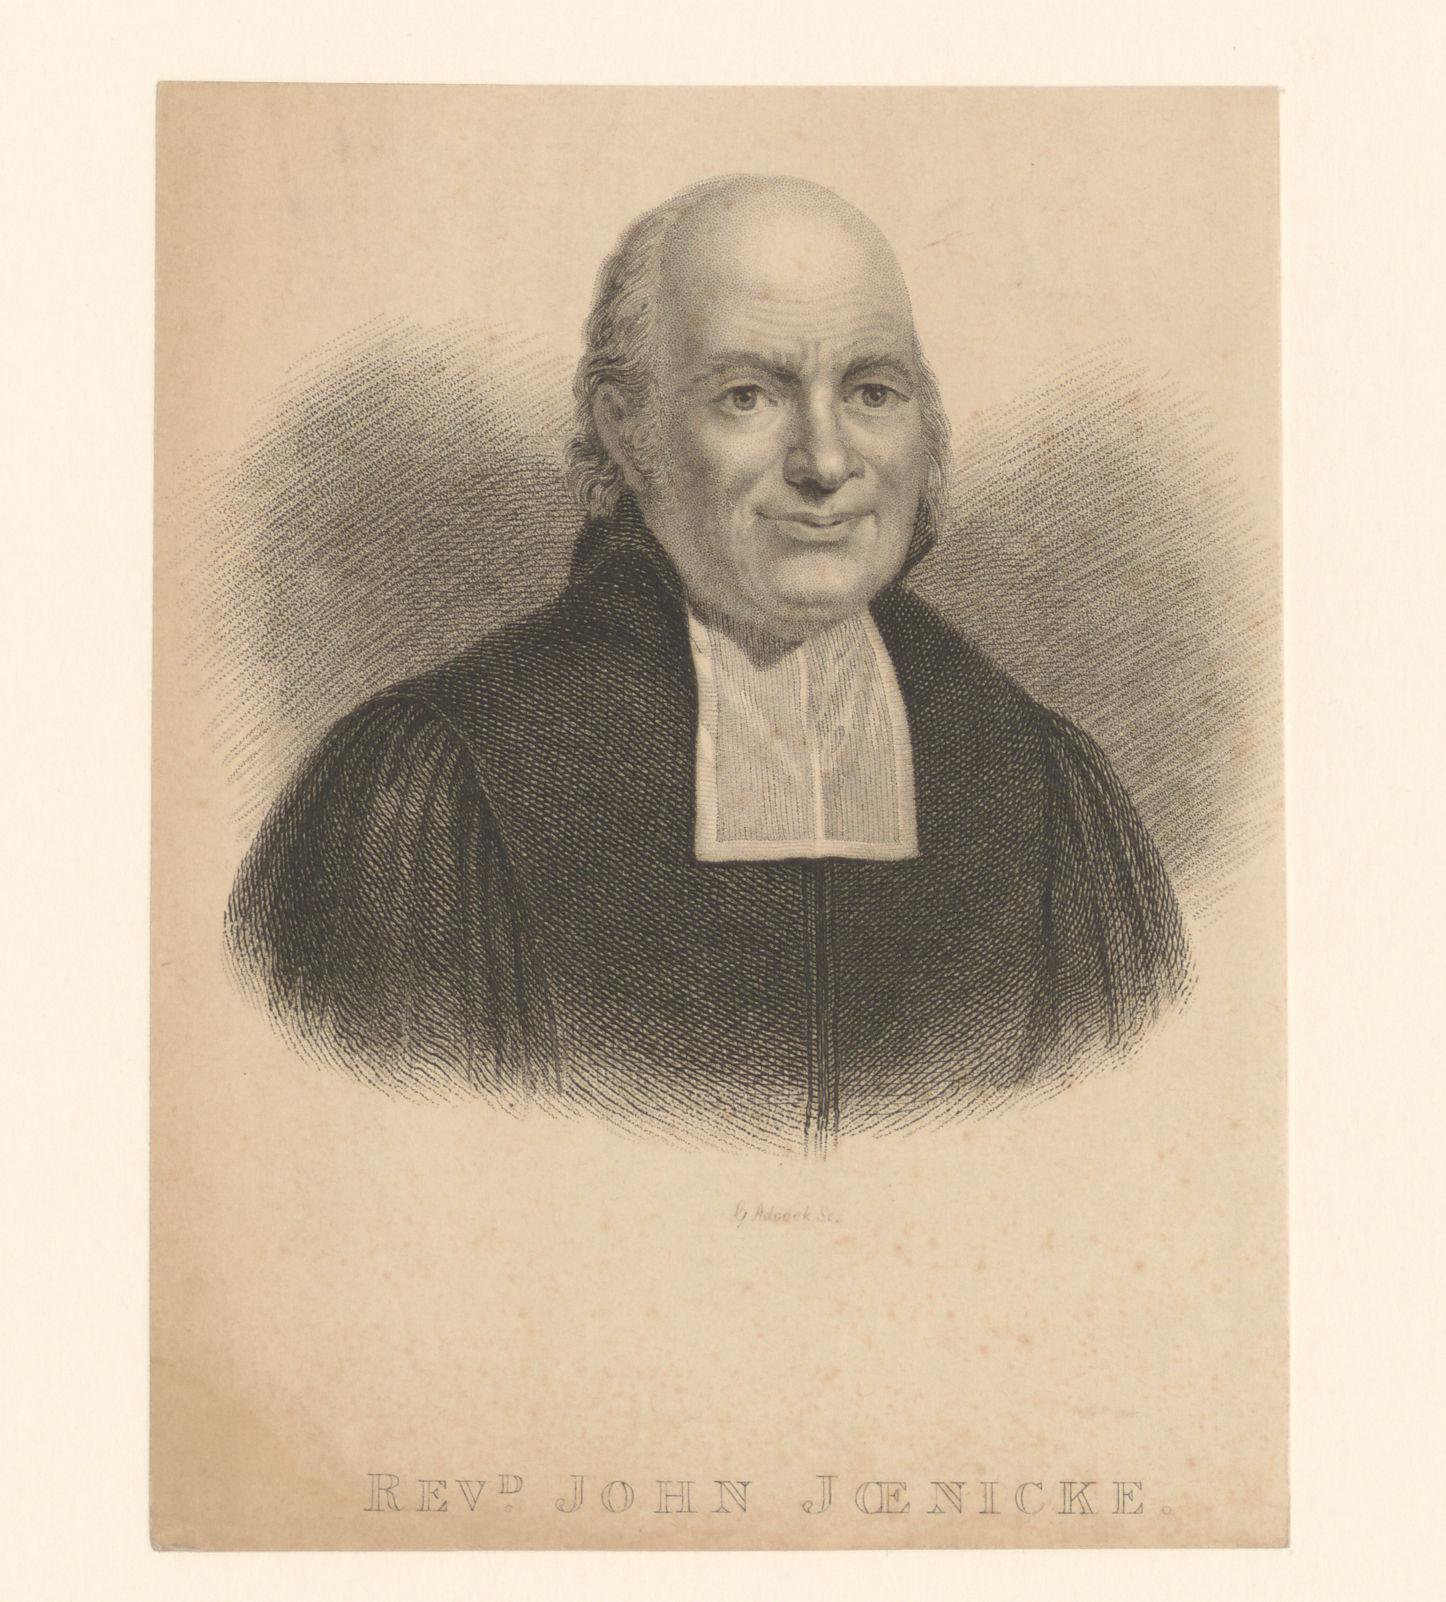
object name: print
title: Portret van Johannes Jaenicke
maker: george henry adcock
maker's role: print maker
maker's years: 1803-1851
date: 1813-1827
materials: paper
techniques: etching, engraving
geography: england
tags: historical persons, functionaries and dignitaries (with name) ~ protestant churches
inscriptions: collector's mark: Lugt 2233